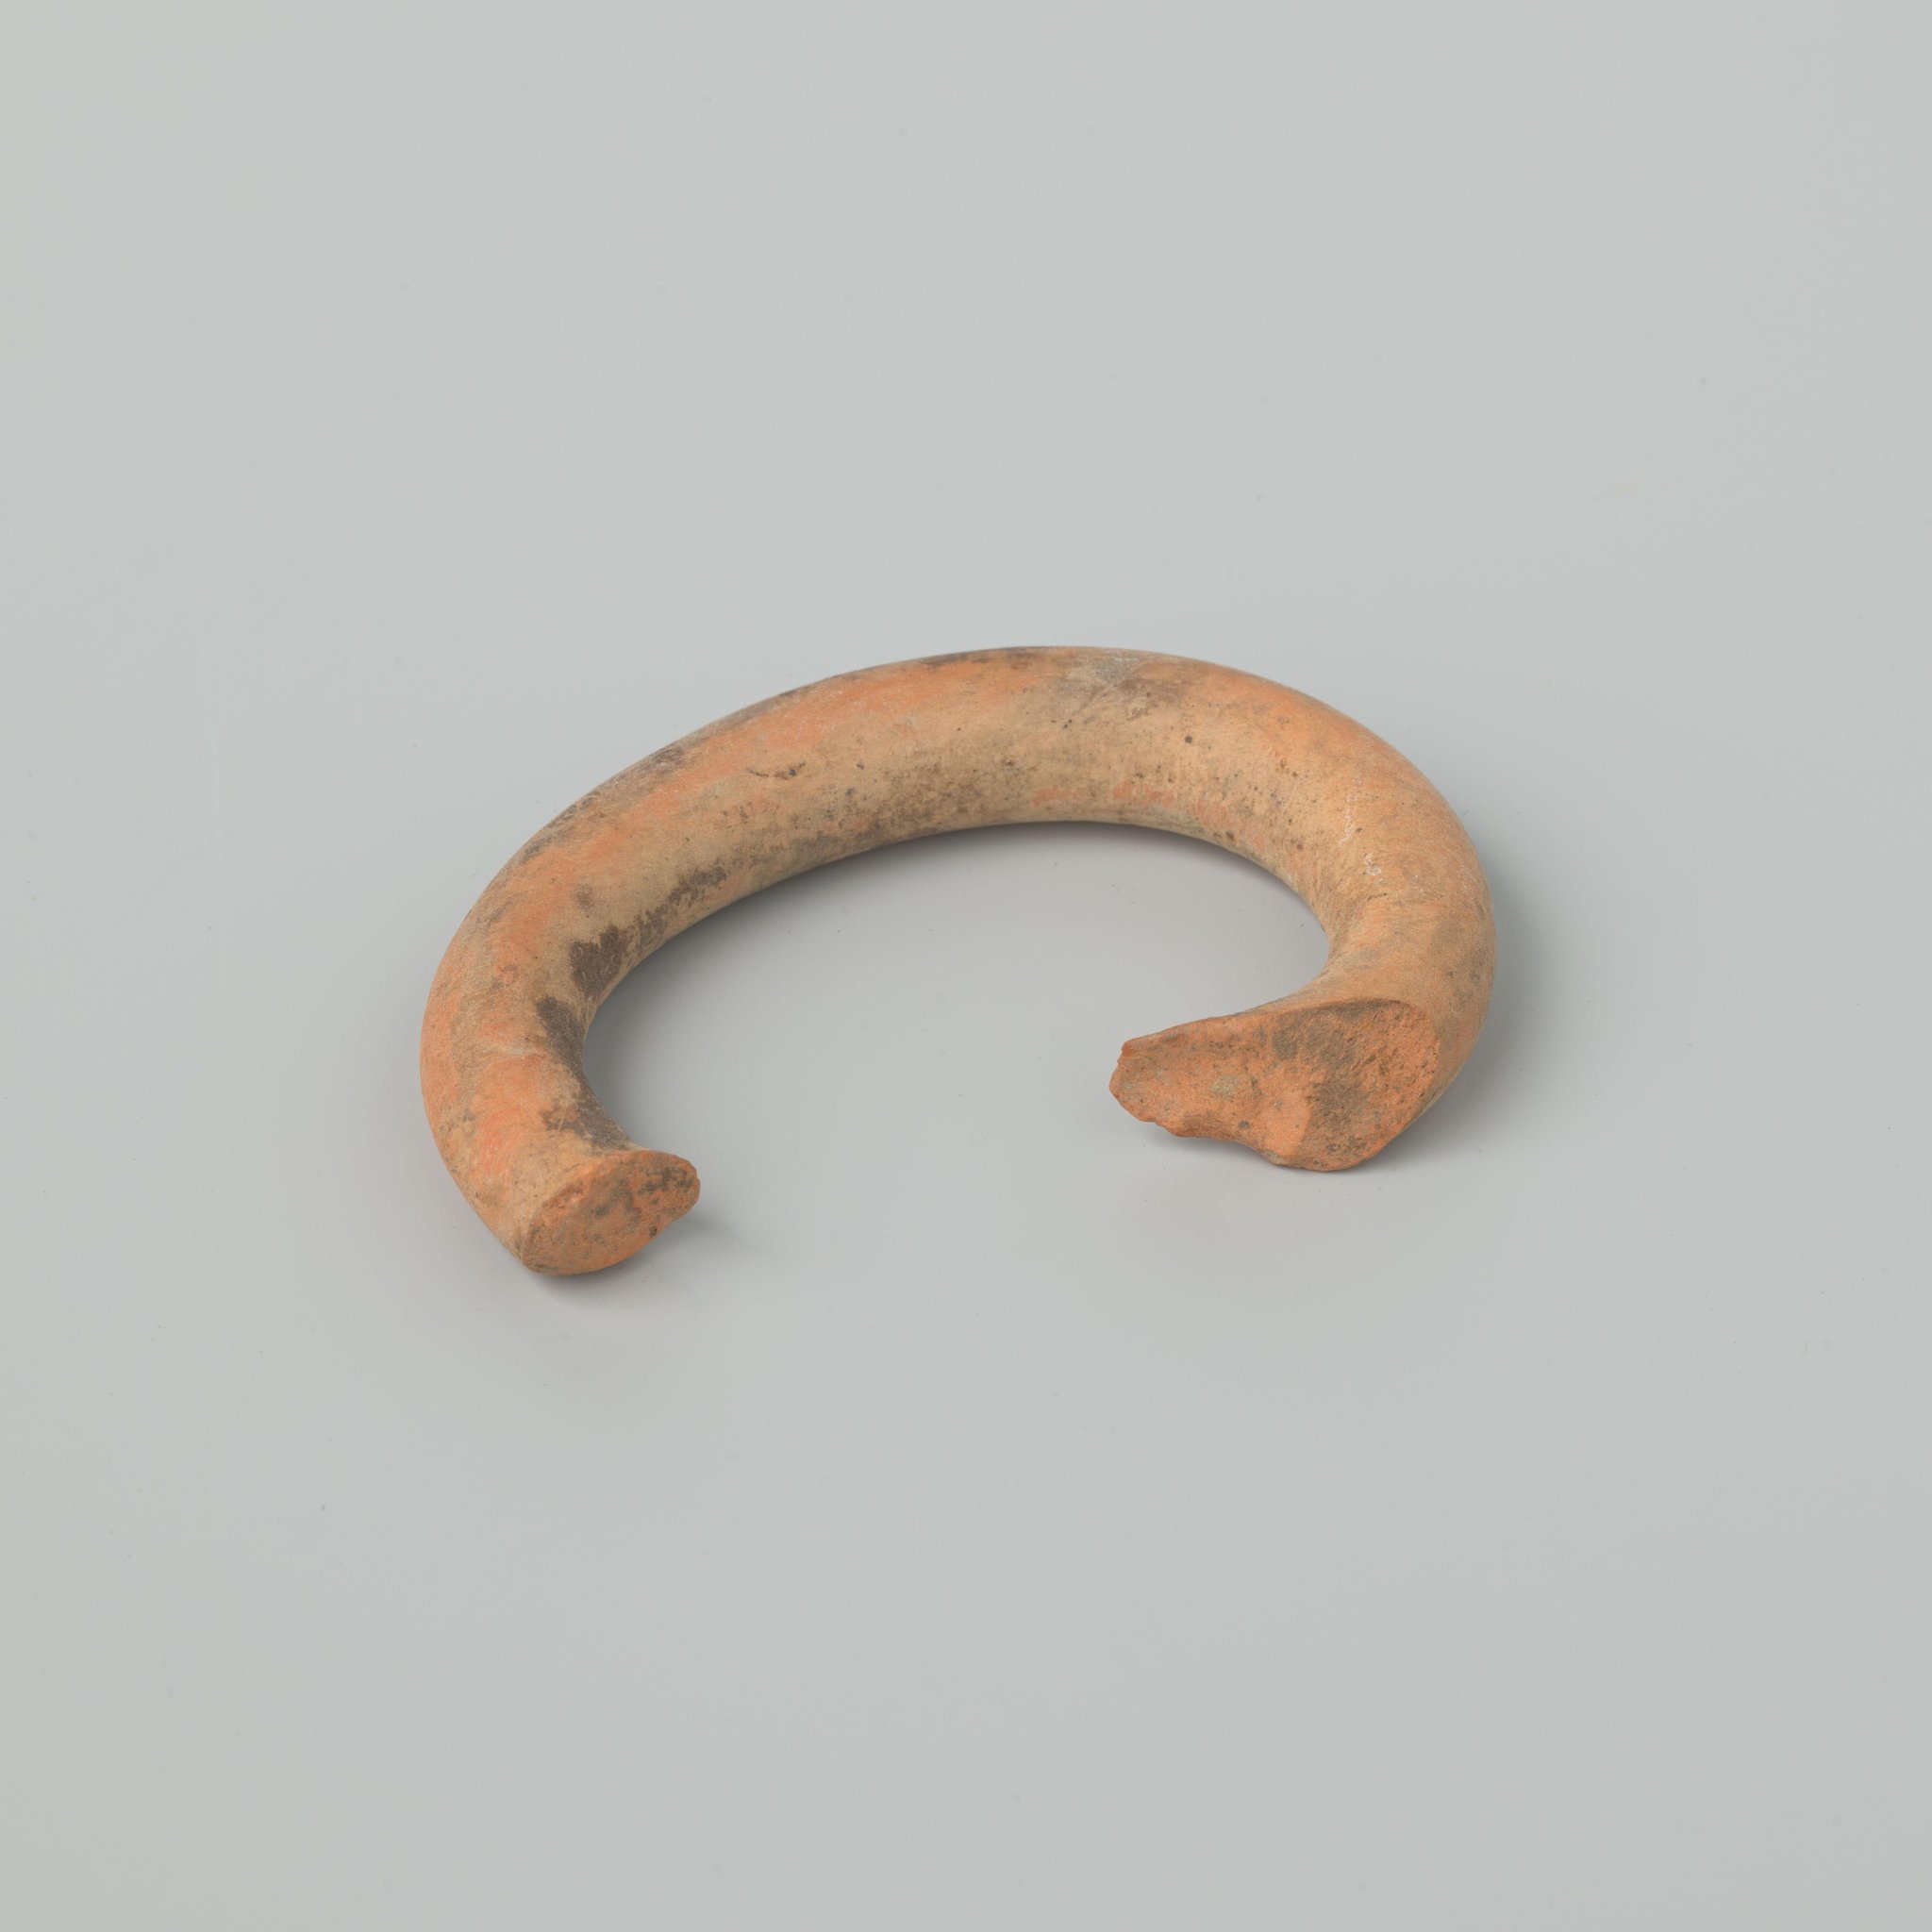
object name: lug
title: Oor van een theepot (De Caluwe bakafval)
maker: jacobus de caluwe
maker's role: plateelbakkerij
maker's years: -1730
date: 1700-1725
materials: earthenware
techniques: firing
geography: delft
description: Toegeschreven aan Jacobus de Caluwe, omdat dit voorwerp samen met gemerkte stukken (‘Jacobus De Caluwe’ en rennend hert) gevonden is op de plaats waar zich De Caluwes tweede werkplaats bevond. Er is een duidelijke stilistische overeenkomst tussen de gemerkte en niet gemerkte voorwerpen uit deze archeologische vondst.